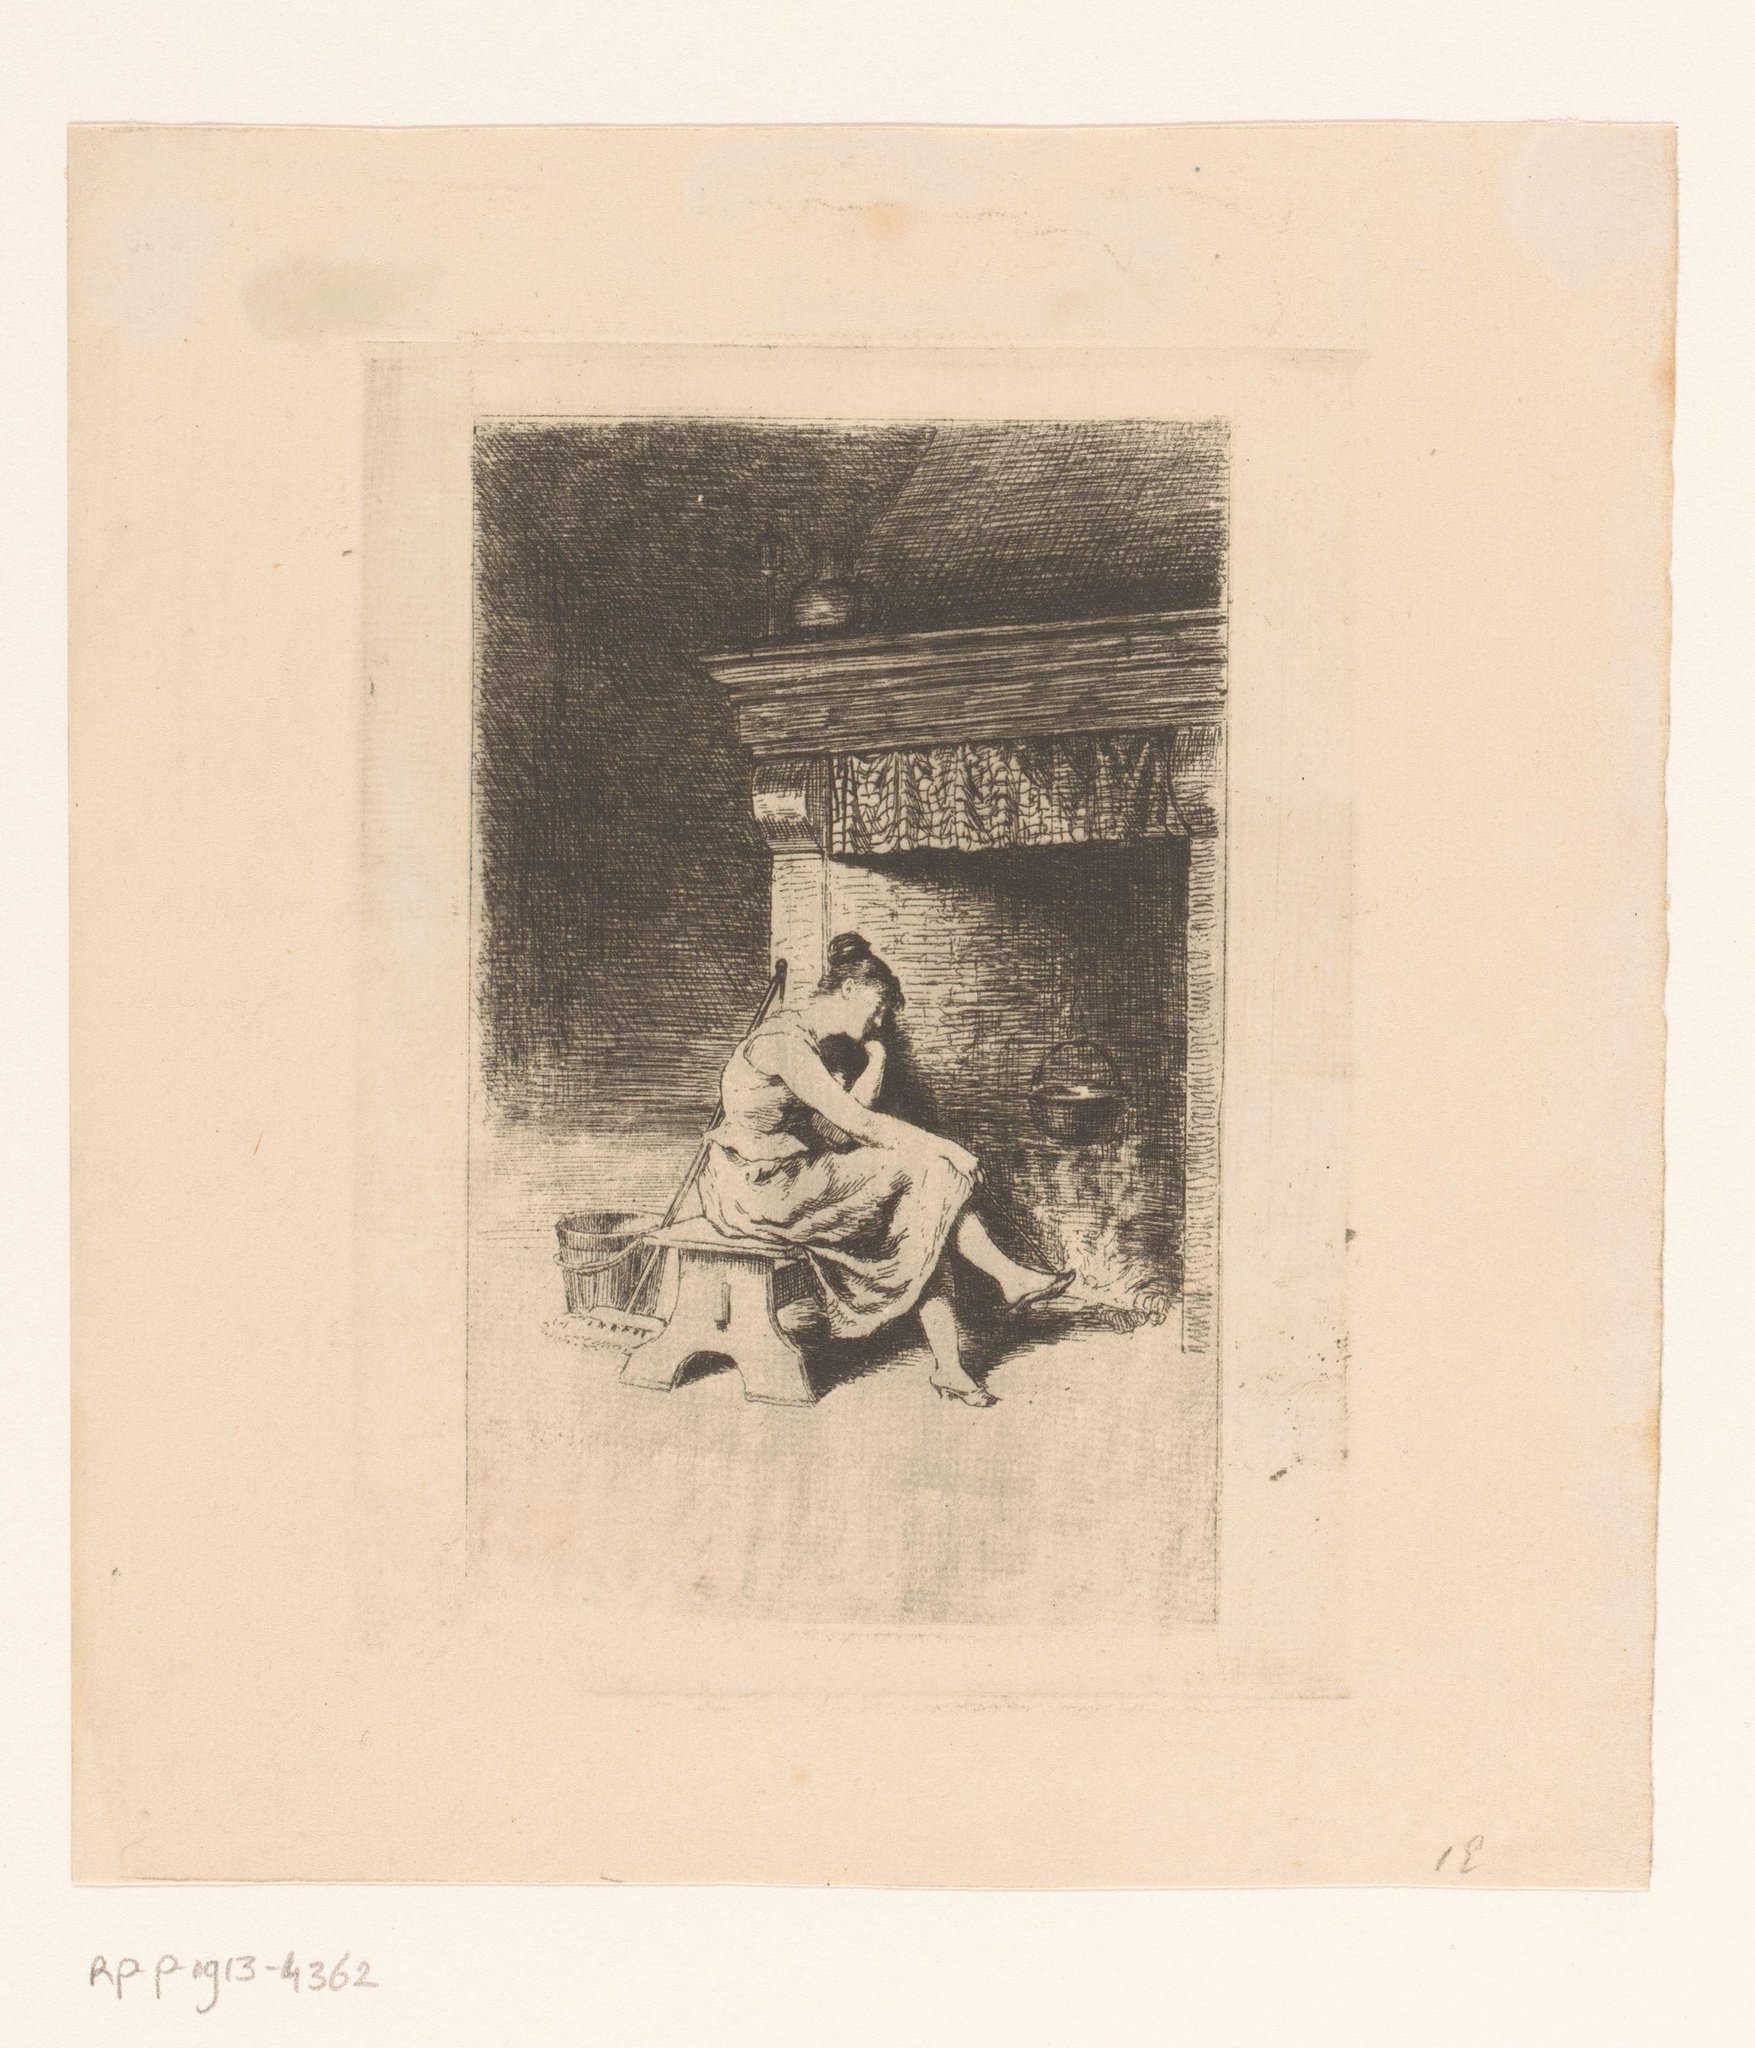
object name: print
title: Jonge vrouw zittend bij een haard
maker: adrien de witte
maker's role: print maker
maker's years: 1850-1935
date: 1879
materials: paper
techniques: drypoint, etching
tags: adult woman, open hearth, fire-place, kitchen-utensils (with name)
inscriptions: collector's mark: Lugt 2228